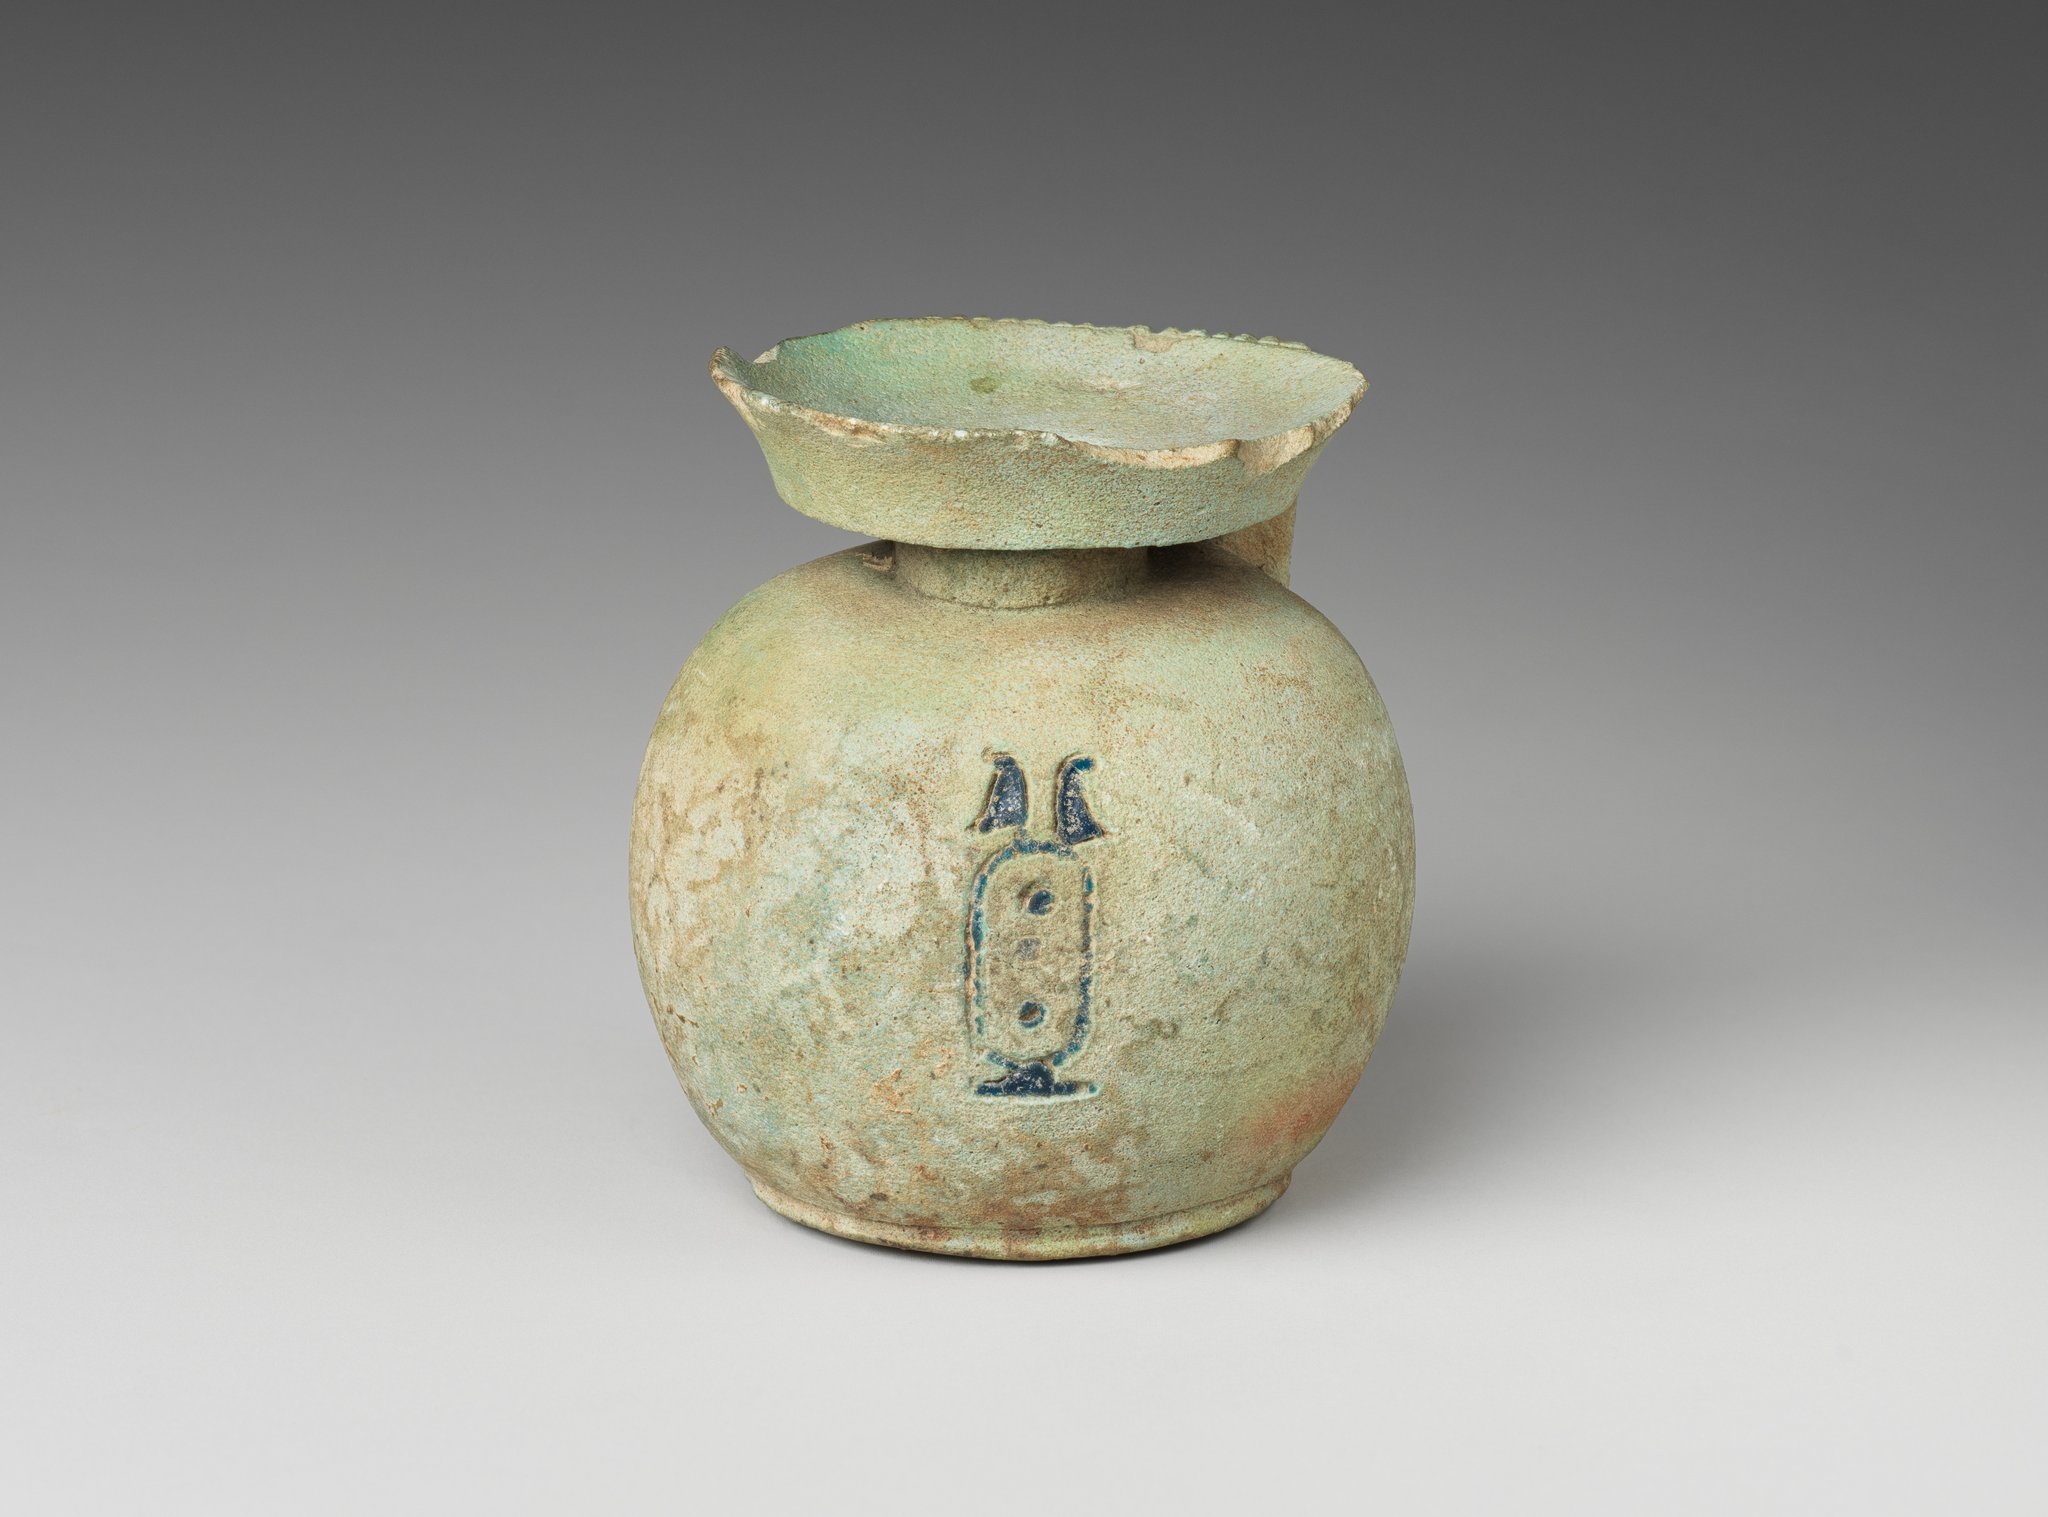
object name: jar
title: Jar (Aryballos) with a cartouche derived from names of Apries or Amasis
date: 600-501 BCE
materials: faience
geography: egypt